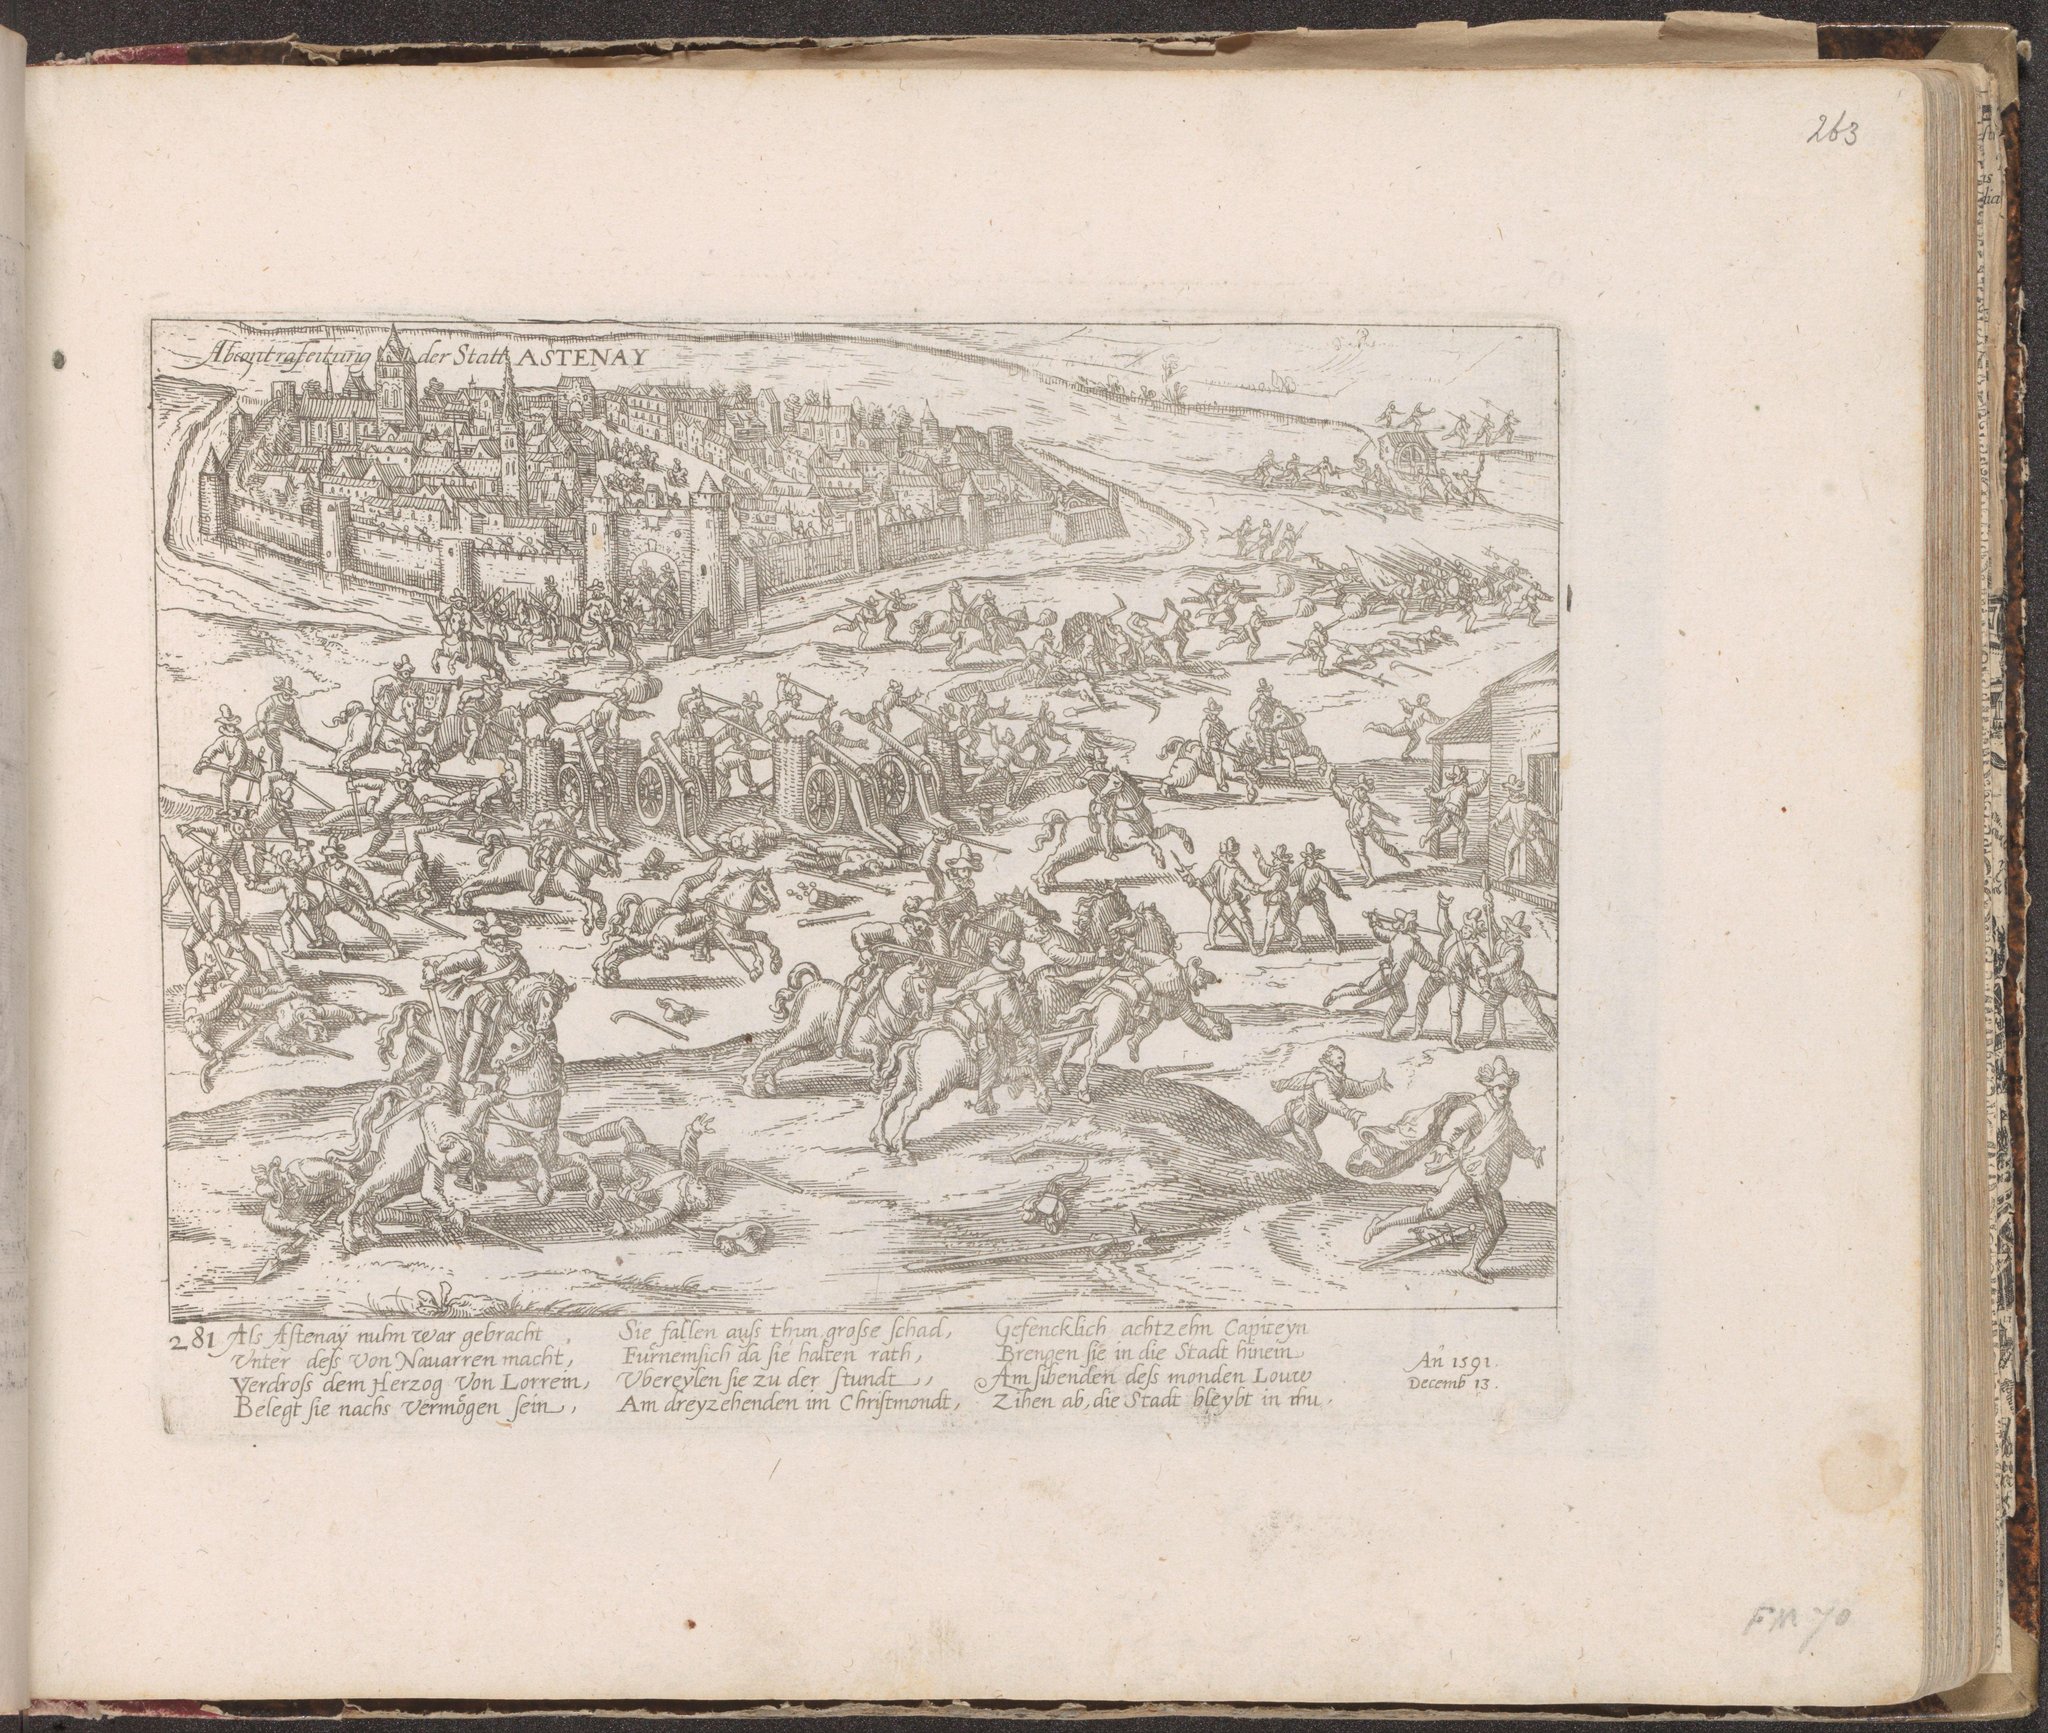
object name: print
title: Serie 4: Franse, Duitse en Engelse Gebeurtenissen, 1576-1610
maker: frans hogenberg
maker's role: print maker, publisher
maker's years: 1538-1590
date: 1591-1593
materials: paper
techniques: etching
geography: cologne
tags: siege, position war, battle, fighting in general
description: Beleg van Stenay door de hertog van Lotharingen, 13 december 1591. Op de voorgrond gevechten van man tot man. Boven de ommuurde stad Astenay. Met onderschrift van 12 regels in het Duits. Linksonder genummerd: 281. De prent maakt deel uit van een album.